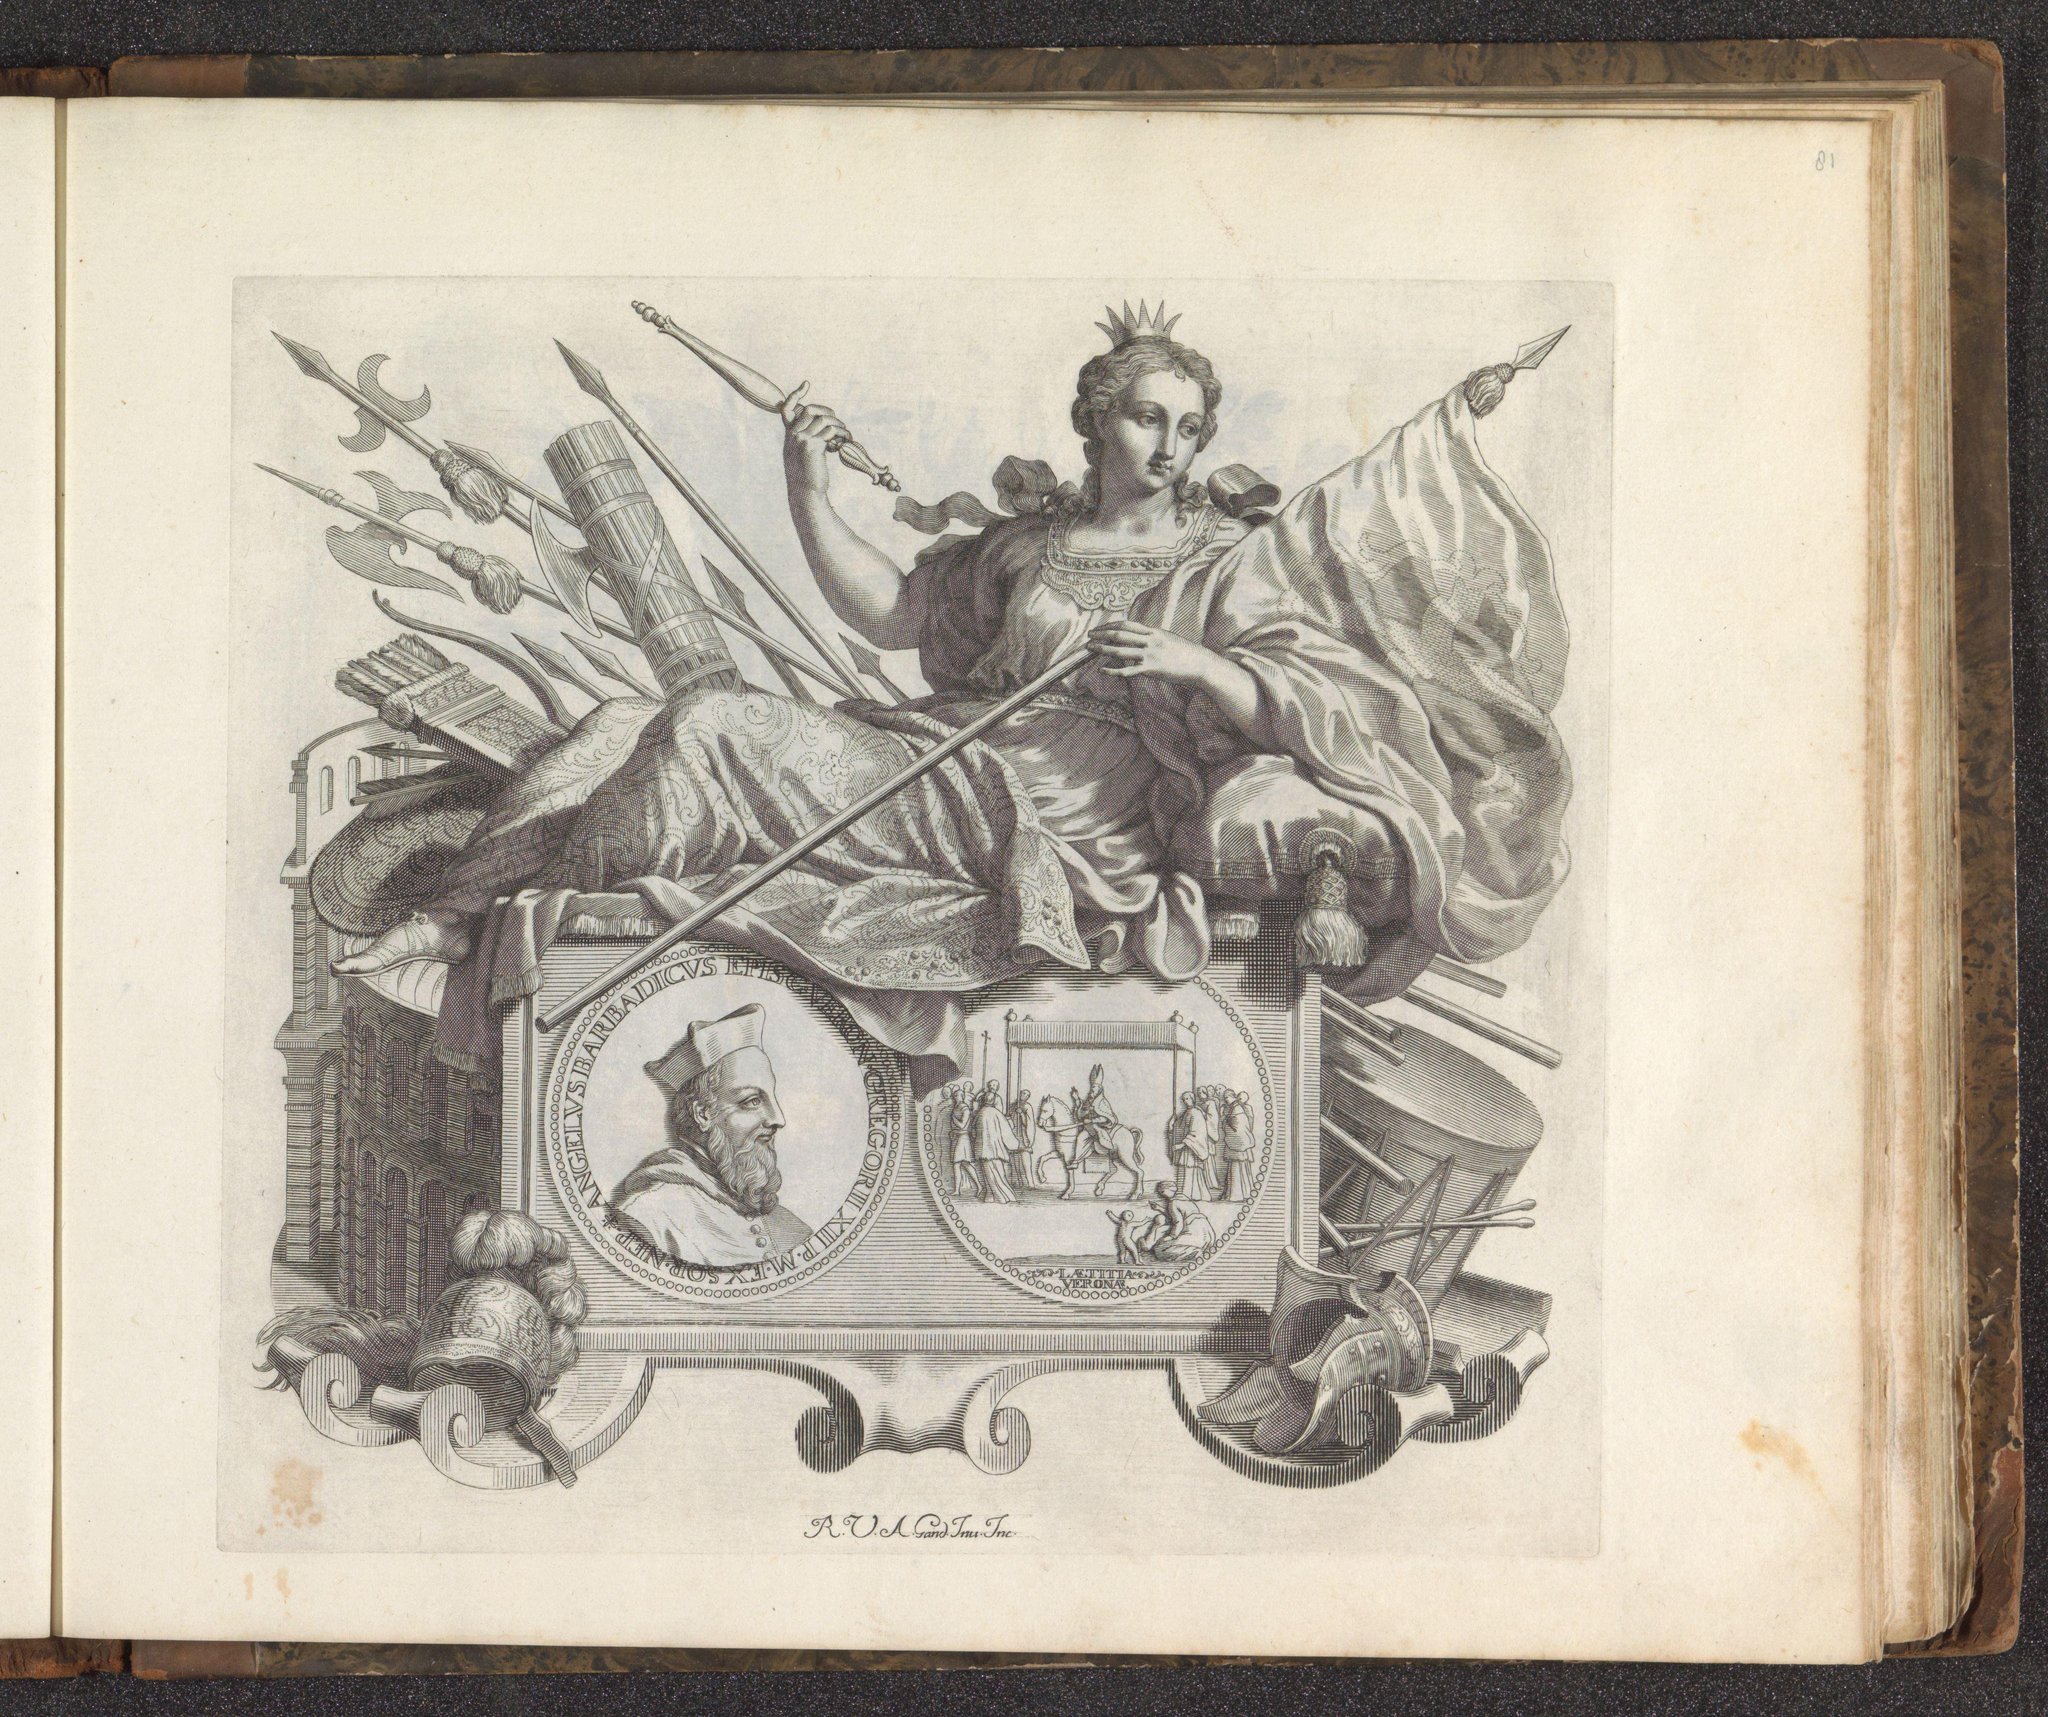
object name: album leaf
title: Numismata virorum illustrium ex Barbadica gente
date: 1673-1743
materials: paper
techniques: engraving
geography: rome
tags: venice, (liturgical) equipment of church, medal (considered as a piece of sculpture, regardless of its specific function), weapons, personifications of countries, nations, states, districts, etc. (with name)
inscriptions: collector's mark: Lugt 2228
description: Voetstuk in de vorm van een cartouche. Daarop een medaillon met op de voorkant het portret van bisschop Angelo Barbarigo, in kerkelijk gewaad en met biretta op zijn hoofd. Op de achterkant de bisschop op zijn paard onder een draagbaar baldakijn. Op het voetstuk mogelijk de vrouwelijke personificatie van Italië, met kroon en scepter. Op haar banier staat het wapen van Italië. Verder allerlei wapentuig: speer, fasces, pijlen, trommel, pronkhelm. Links het Colosseum. De prent maakt deel uit van een album.